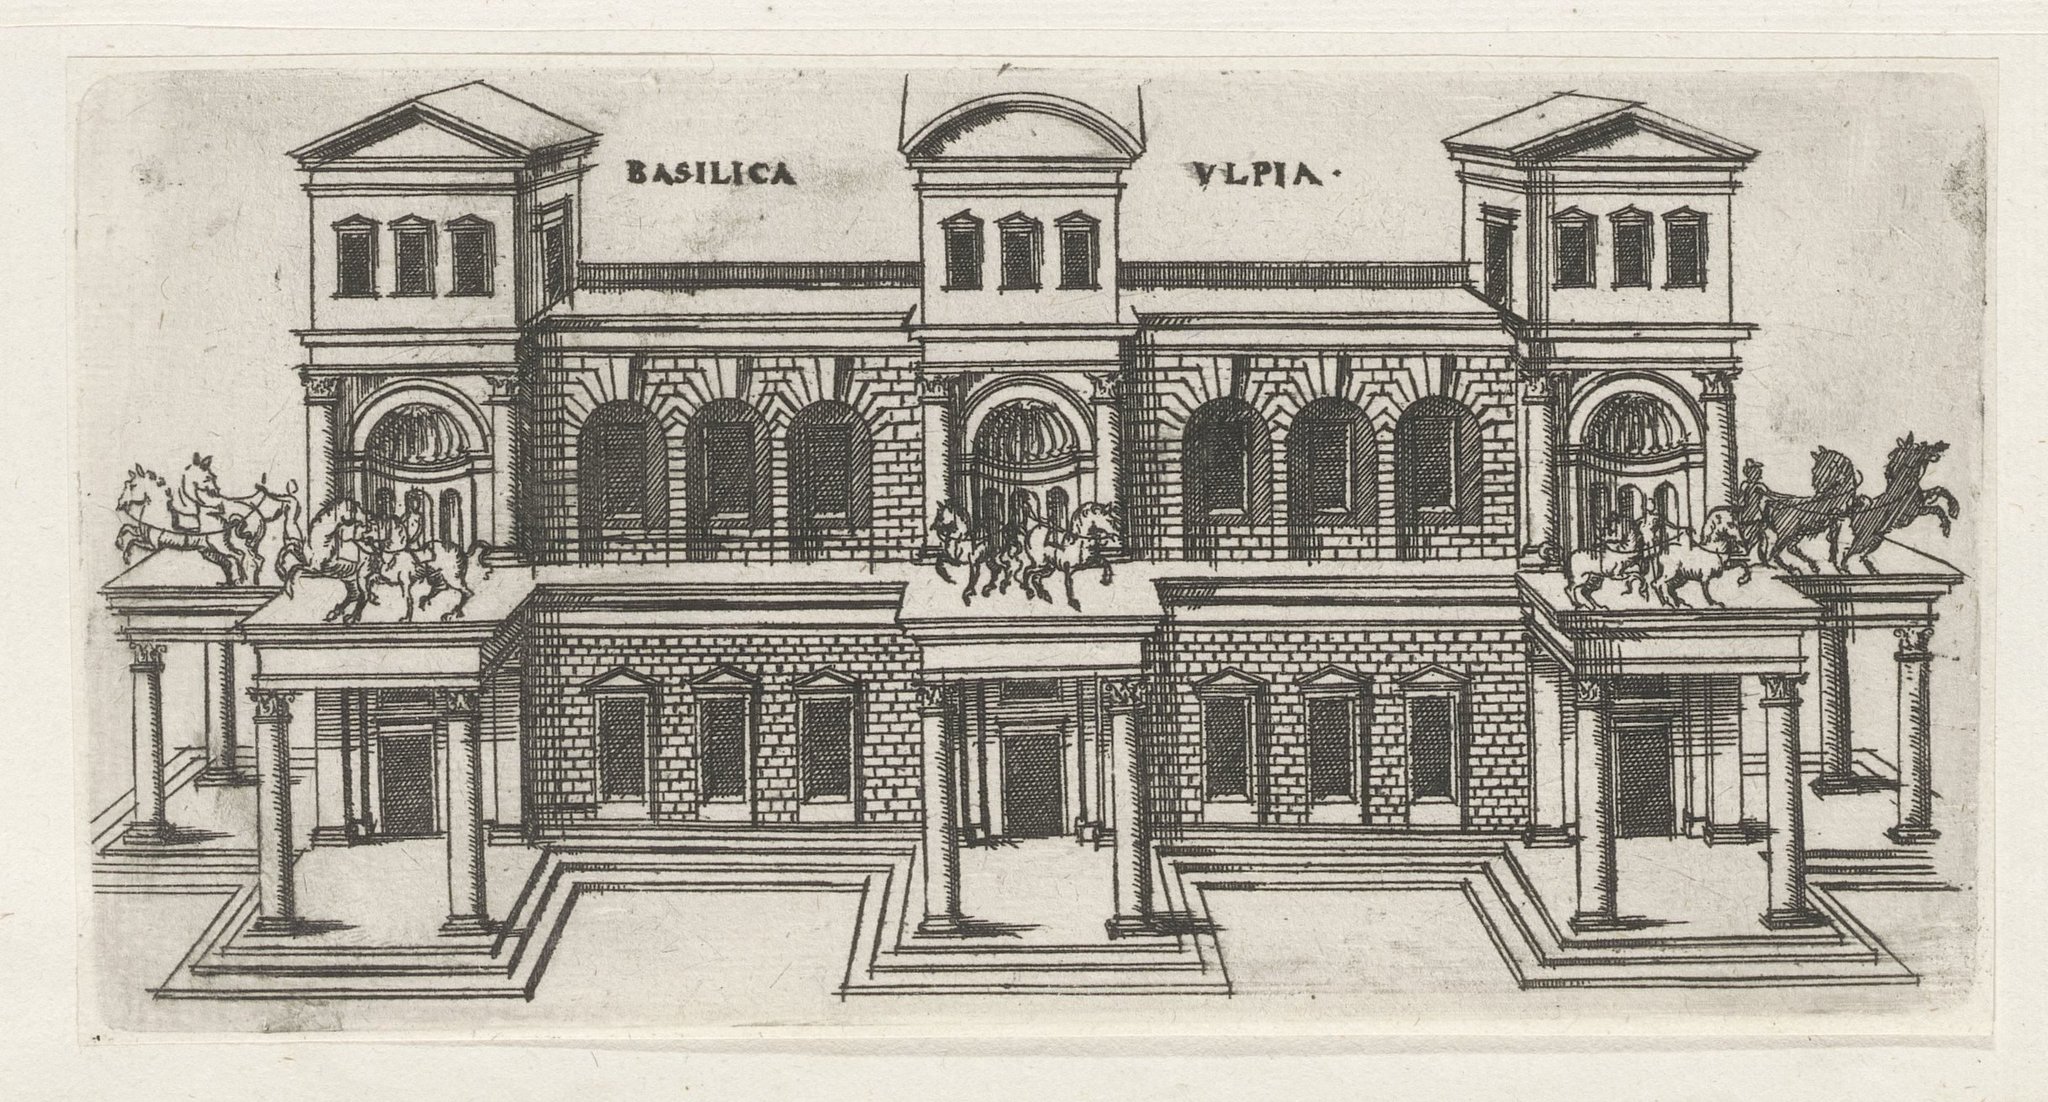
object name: album leaf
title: Magesyn der Italiaense gebouwen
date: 1584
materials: paper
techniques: etching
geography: paris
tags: representation of real building (either existing or having existed)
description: Deze prent maakt deel uit van een serie van 98 prenten gedrukt op 48 bladen. De bladen zijn verknipt en een selectie van de losse prenten is in dit album geplakt.